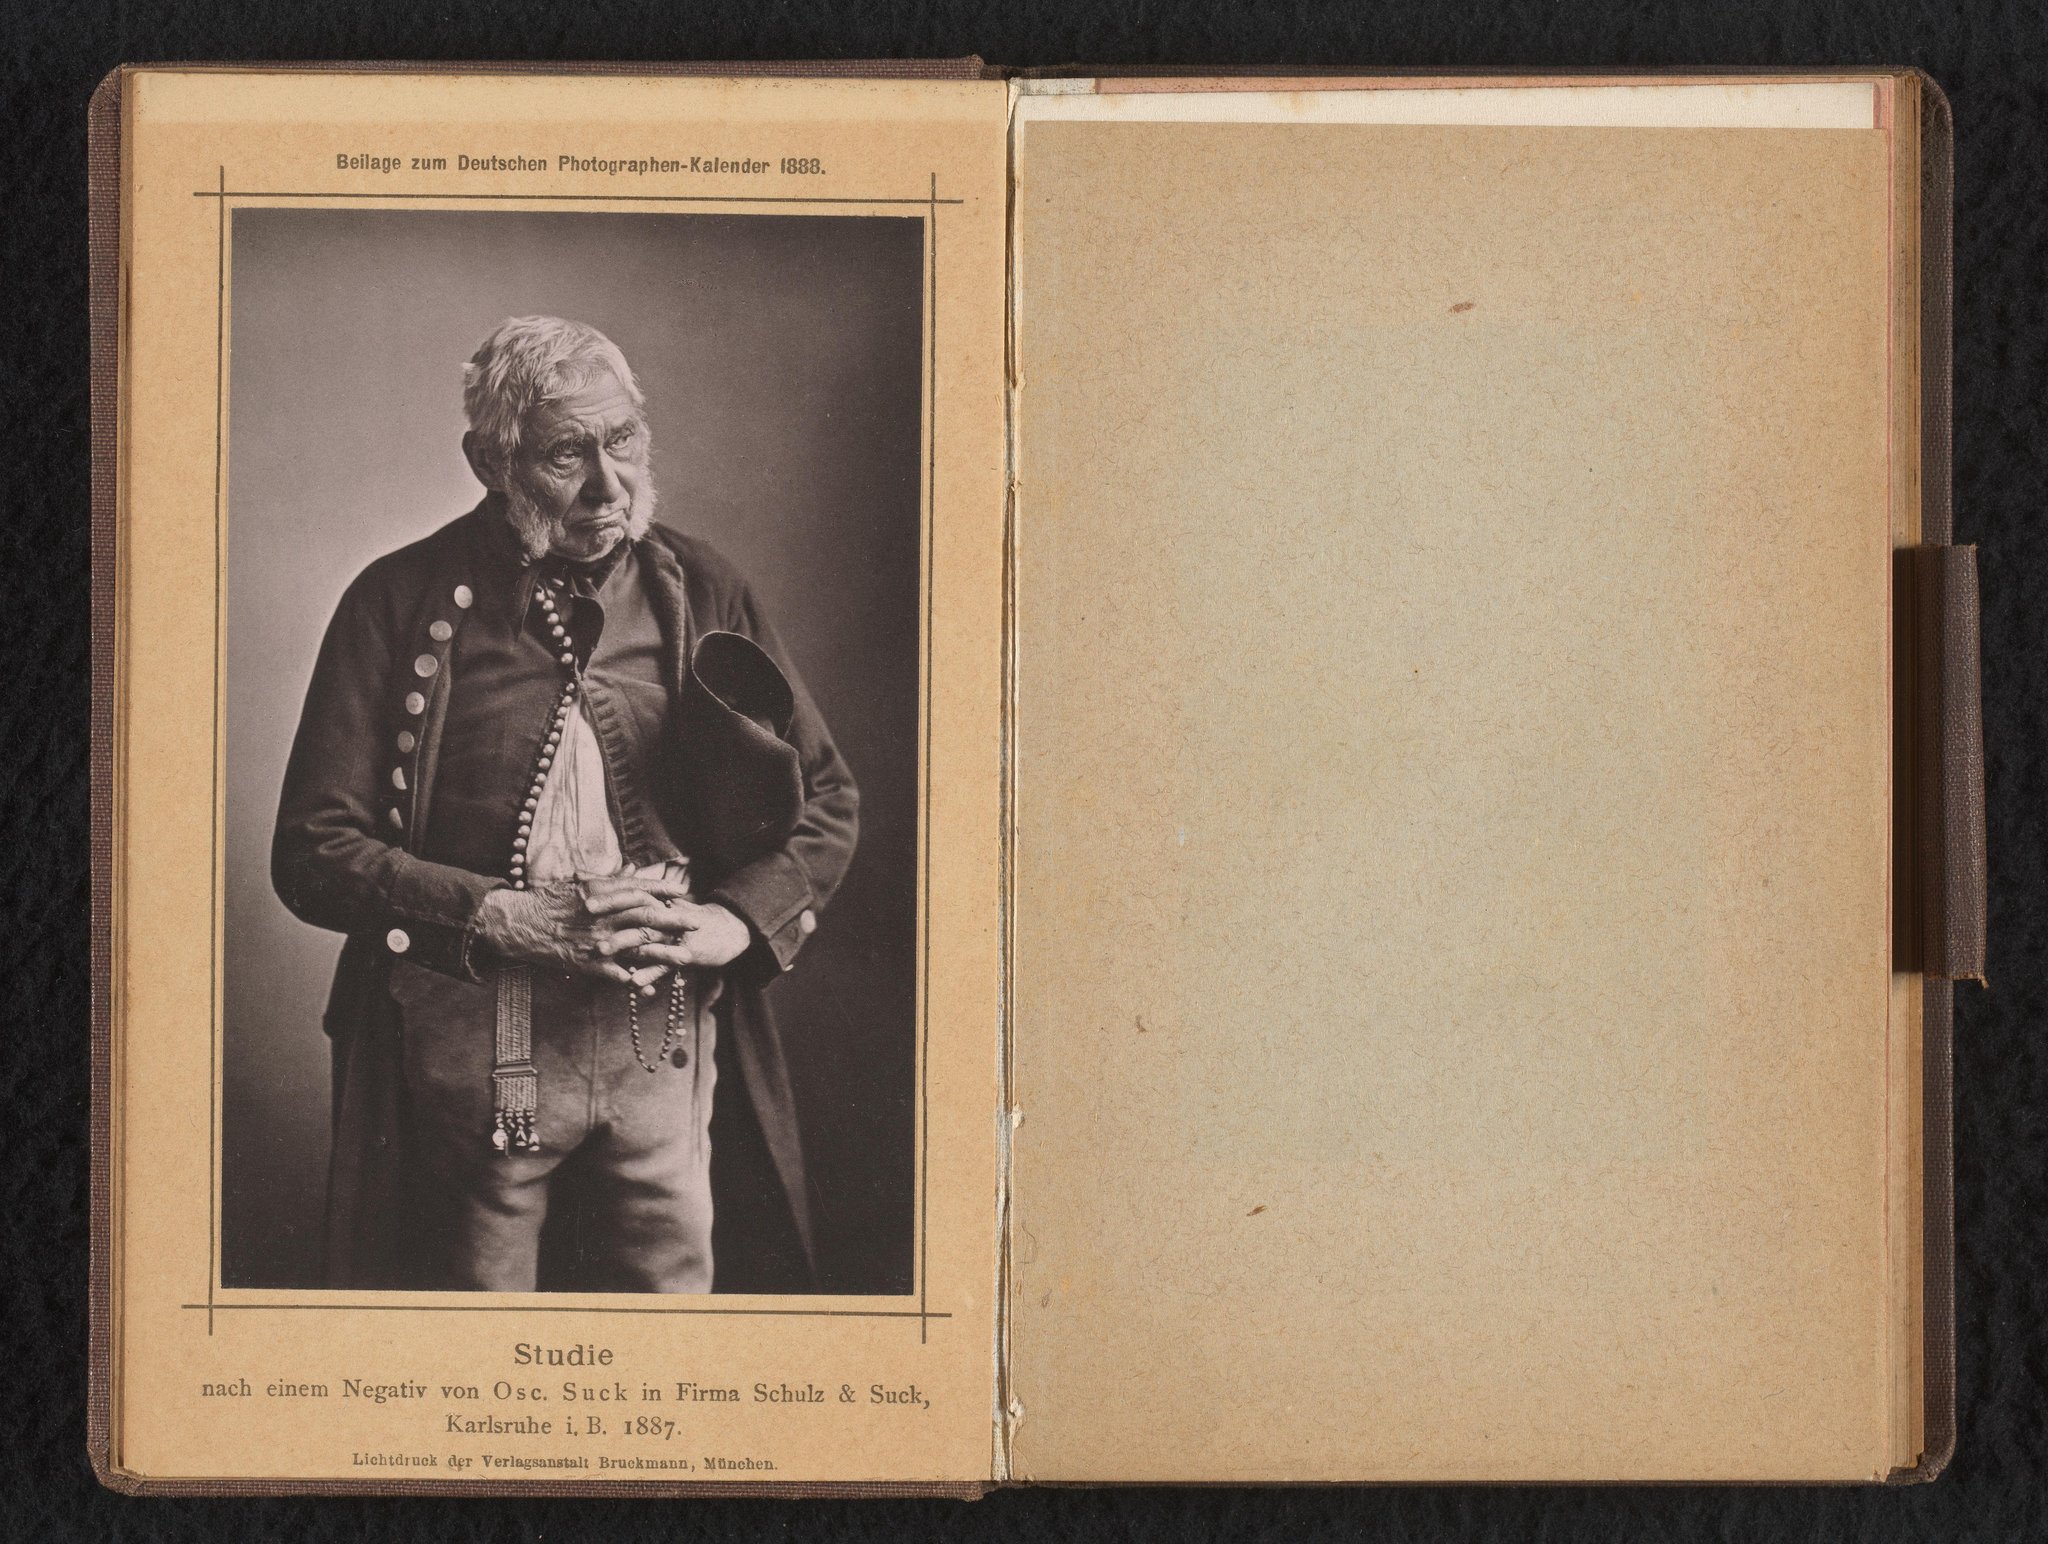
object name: photomechanical print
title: Portret van een oude man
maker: oscar suck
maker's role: fotograaf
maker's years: 1845-1904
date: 1887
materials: paper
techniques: photograph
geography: karlsruhe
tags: old man, anonymous historical person portrayed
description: Prent op tweede ongenummerde pagina na tweede schutblad.